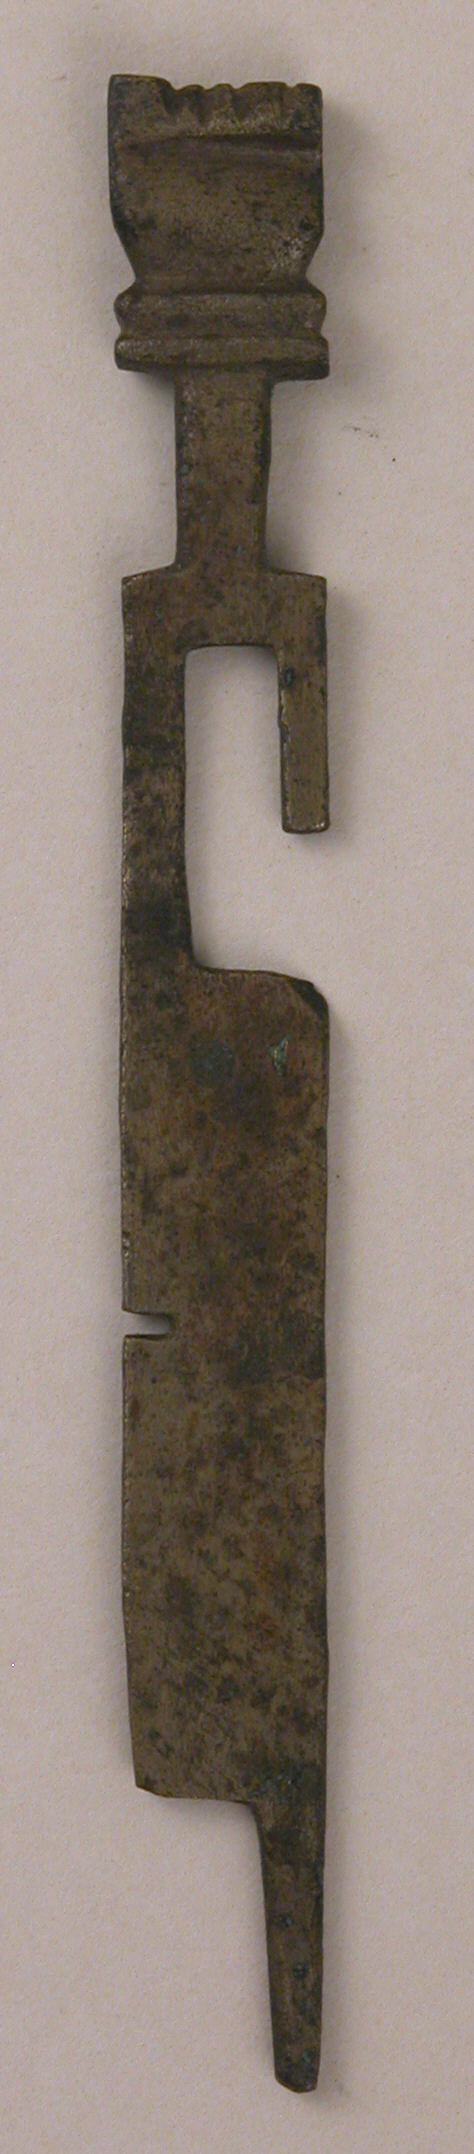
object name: key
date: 401-800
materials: bronze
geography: palestine